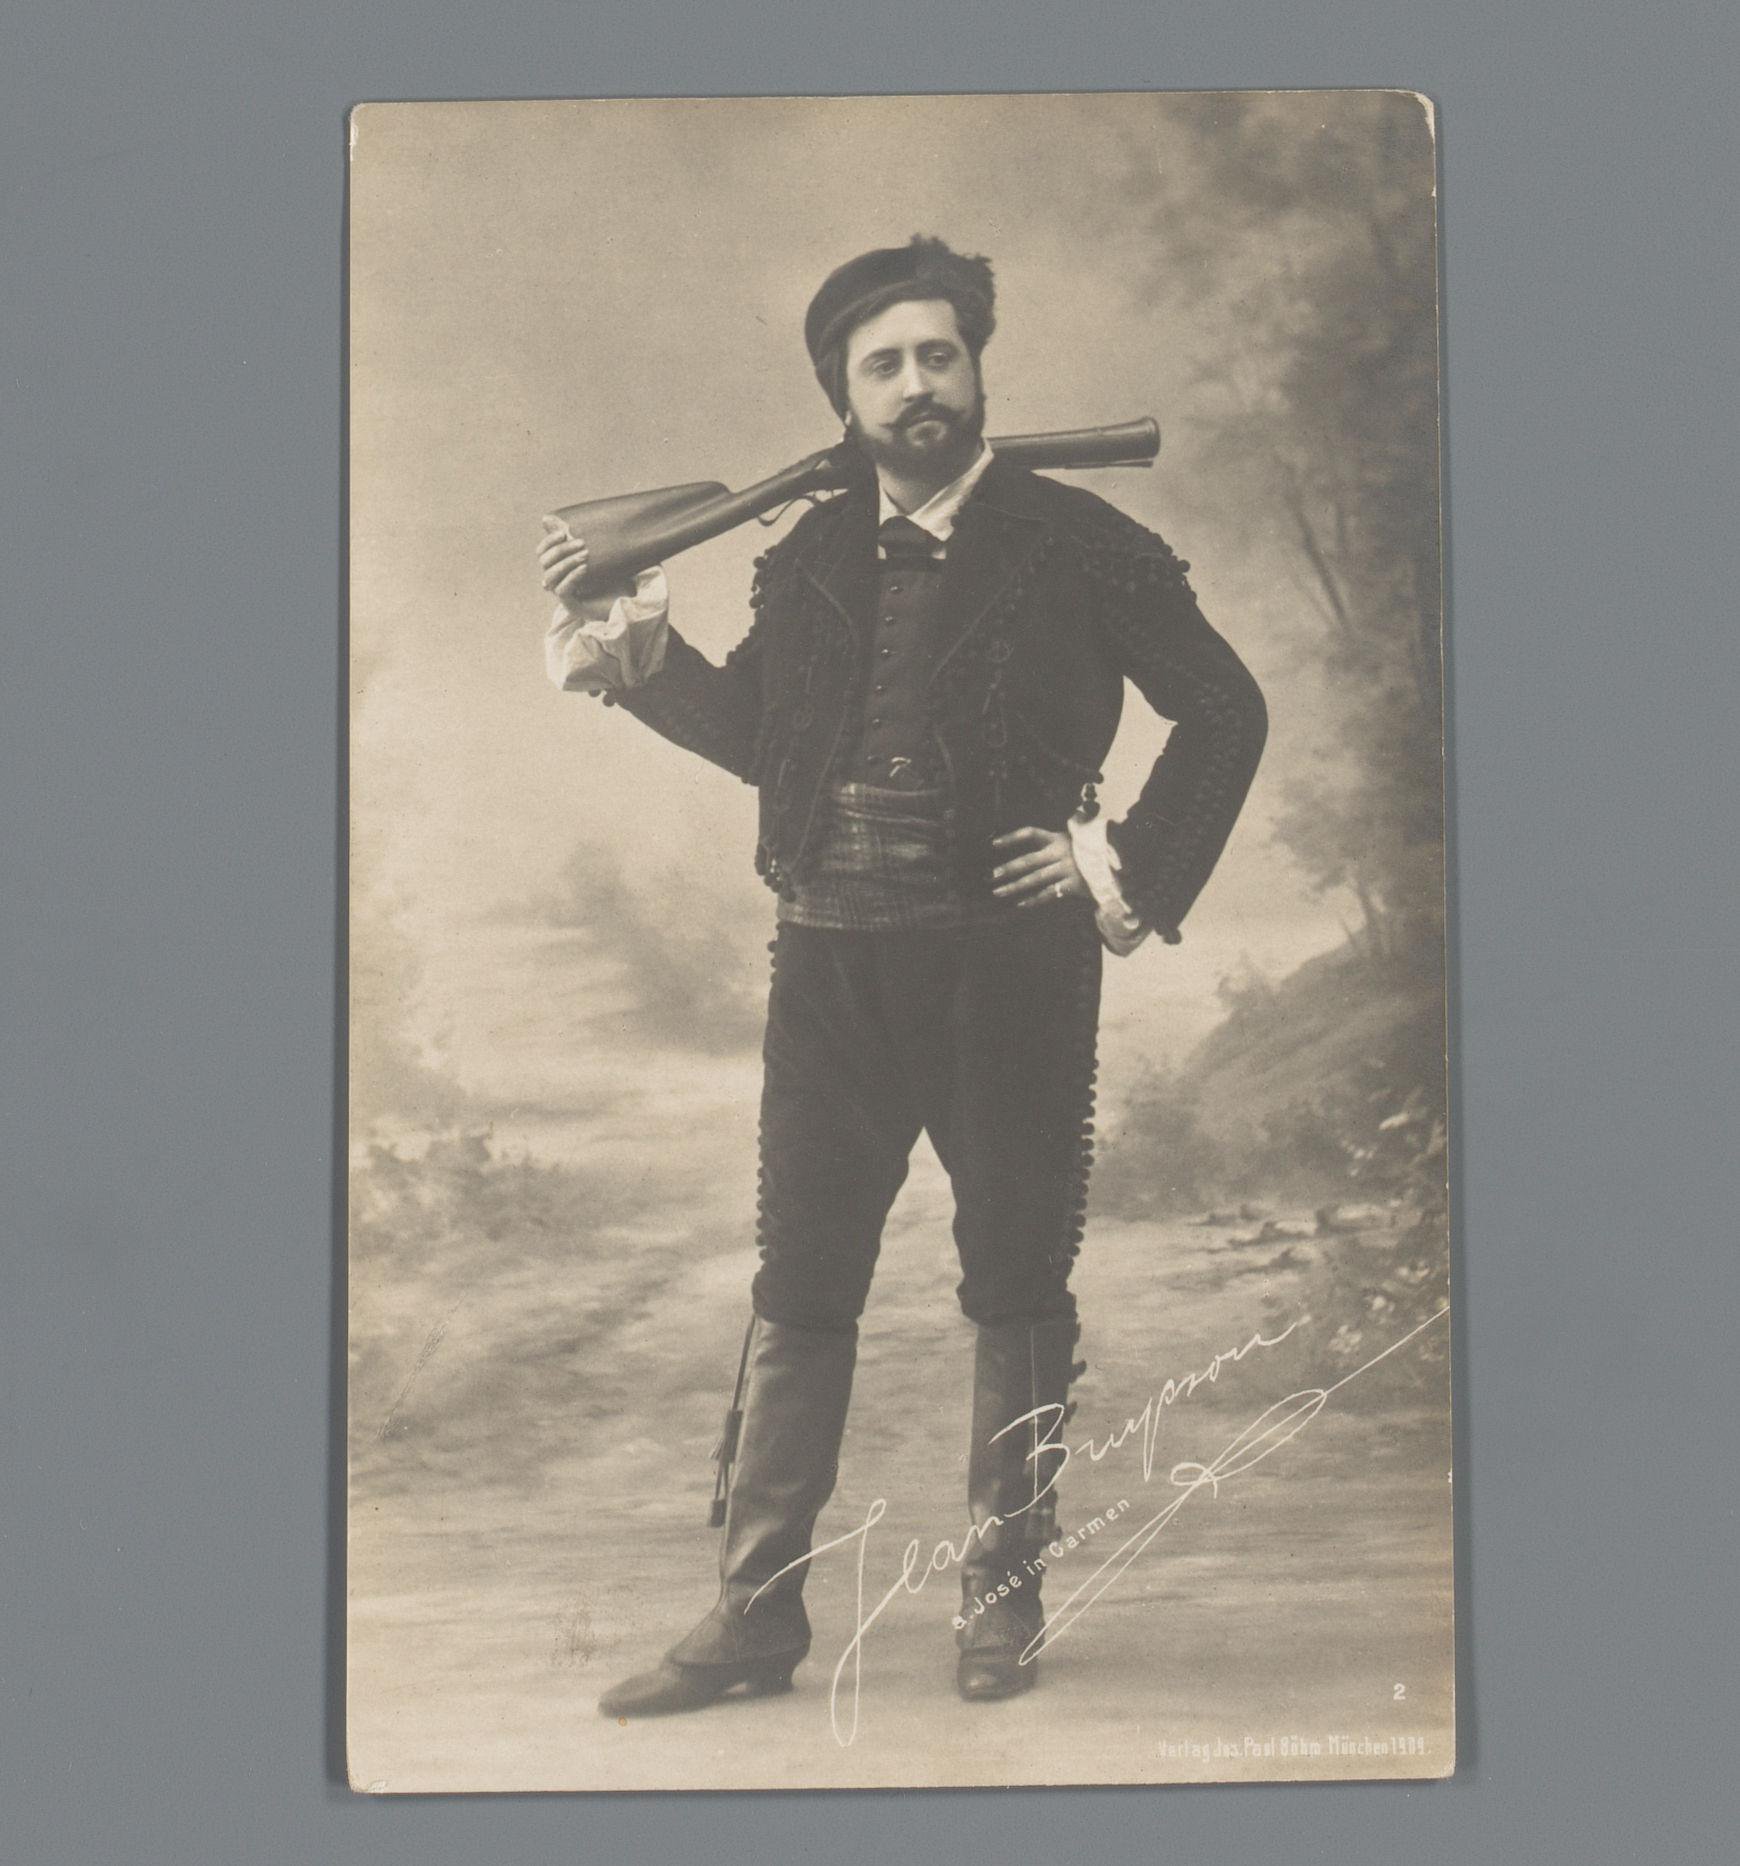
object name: photograph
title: Jean Buysson a. José in Carmen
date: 1909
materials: paper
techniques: gelatin silver print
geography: munich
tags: amsterdam, paris, historical persons (portraits and scenes from the life)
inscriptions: number: ‘2’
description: Portret van Jean Buysson als José in Carmen.